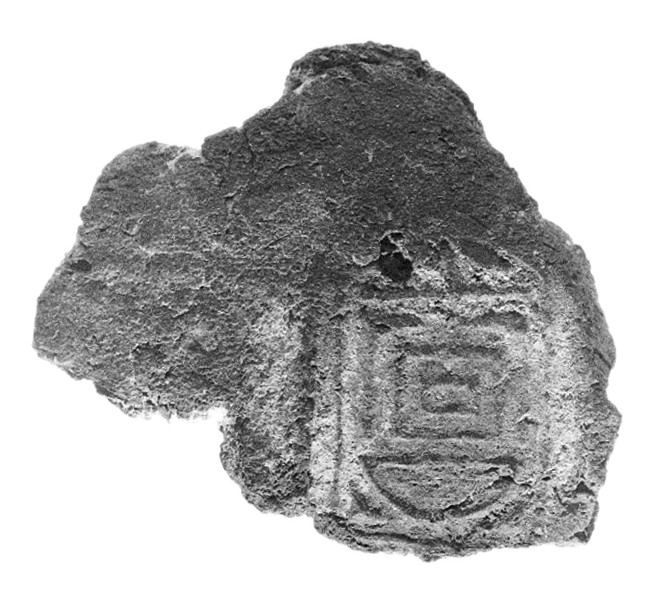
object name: sealing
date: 1981-1640 BCE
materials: mud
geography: egypt